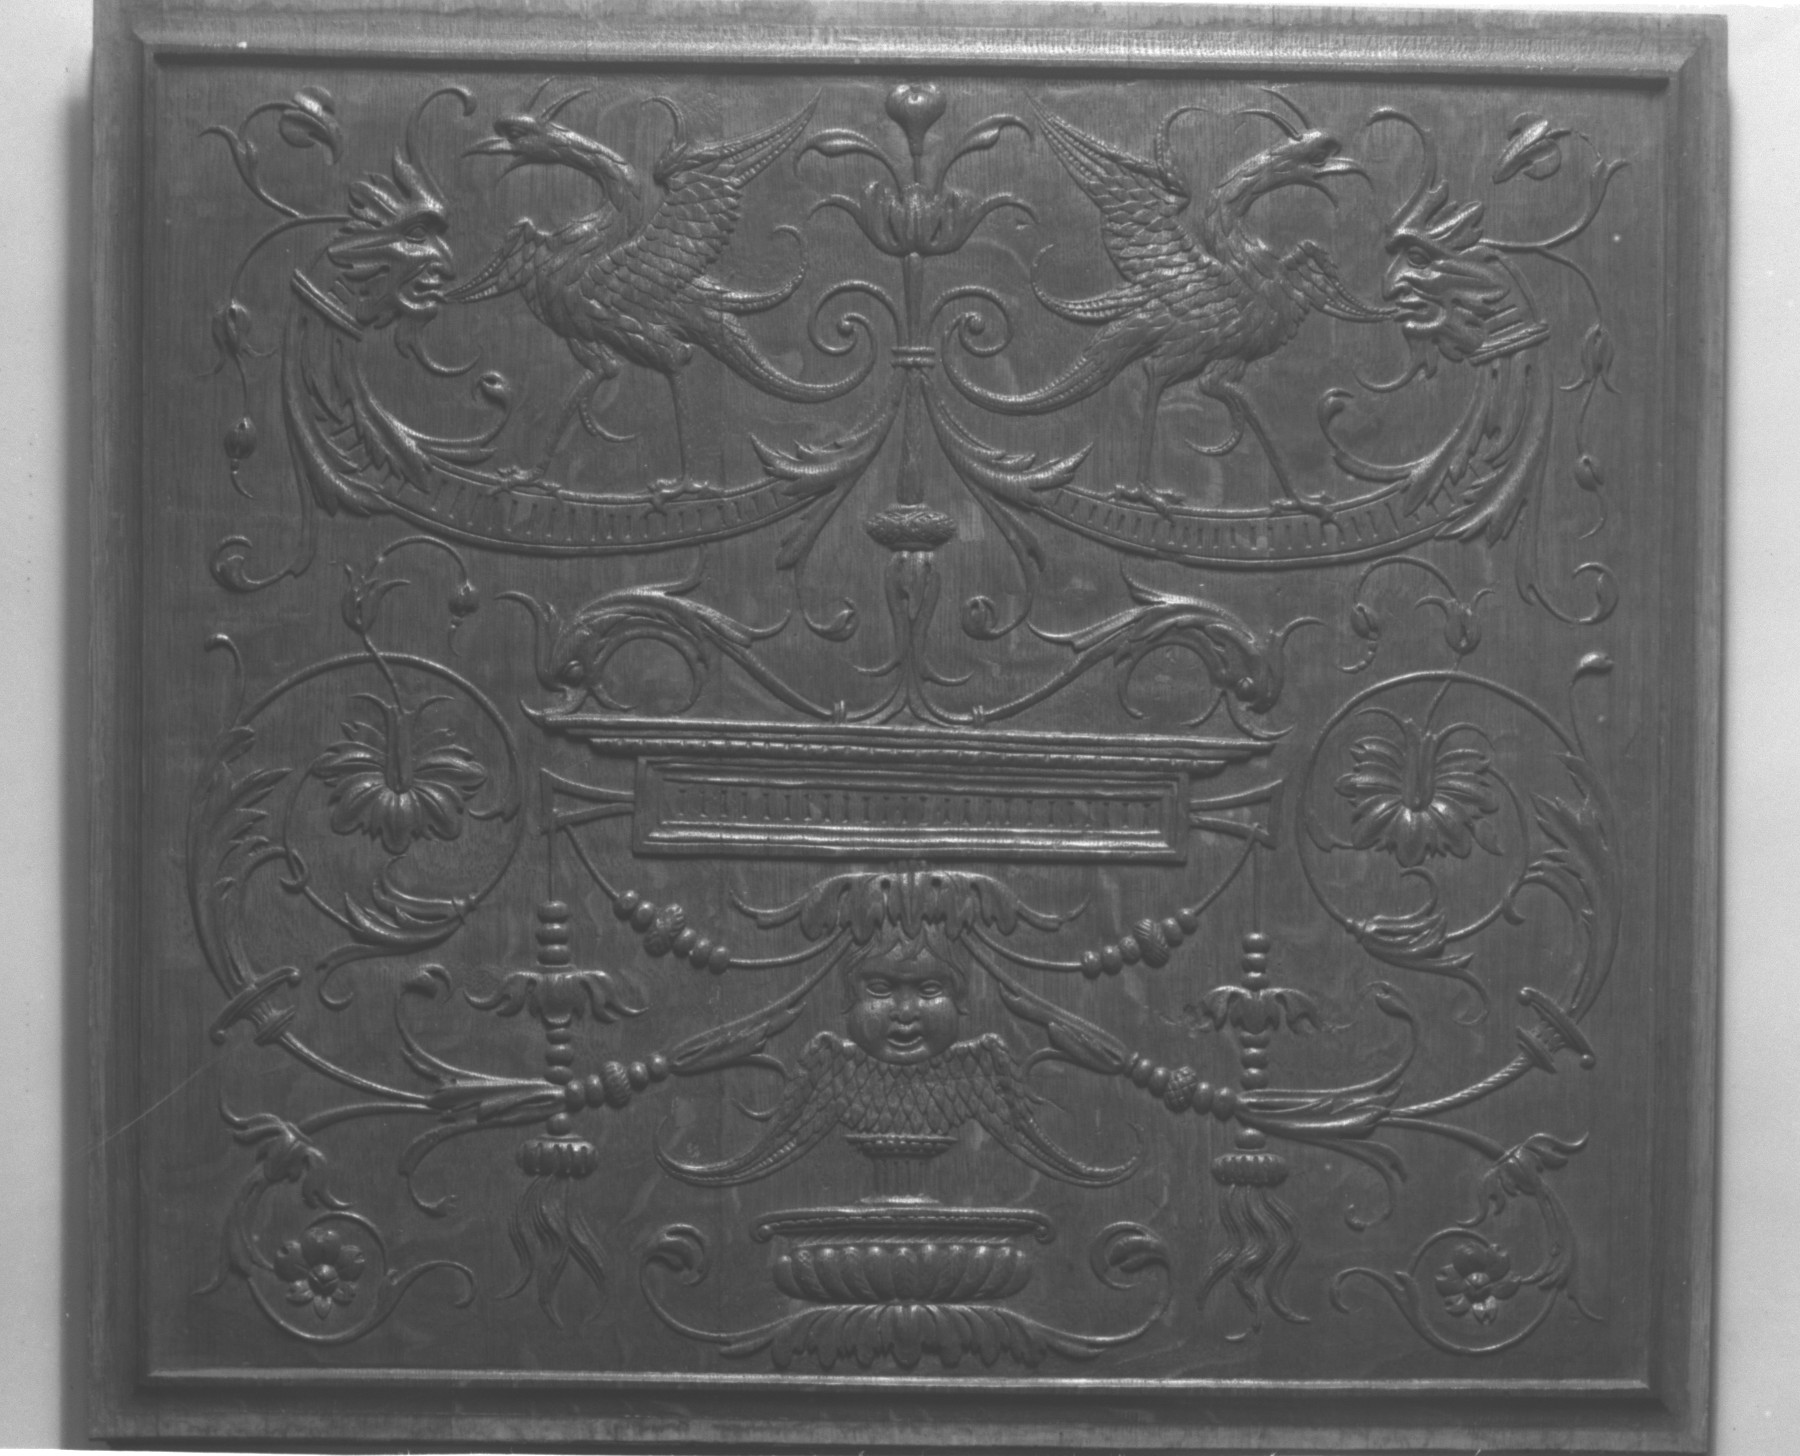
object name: panel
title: Panel (part of a set)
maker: nicolas castille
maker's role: maker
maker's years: 1503-1521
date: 1510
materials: wood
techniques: carving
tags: birds